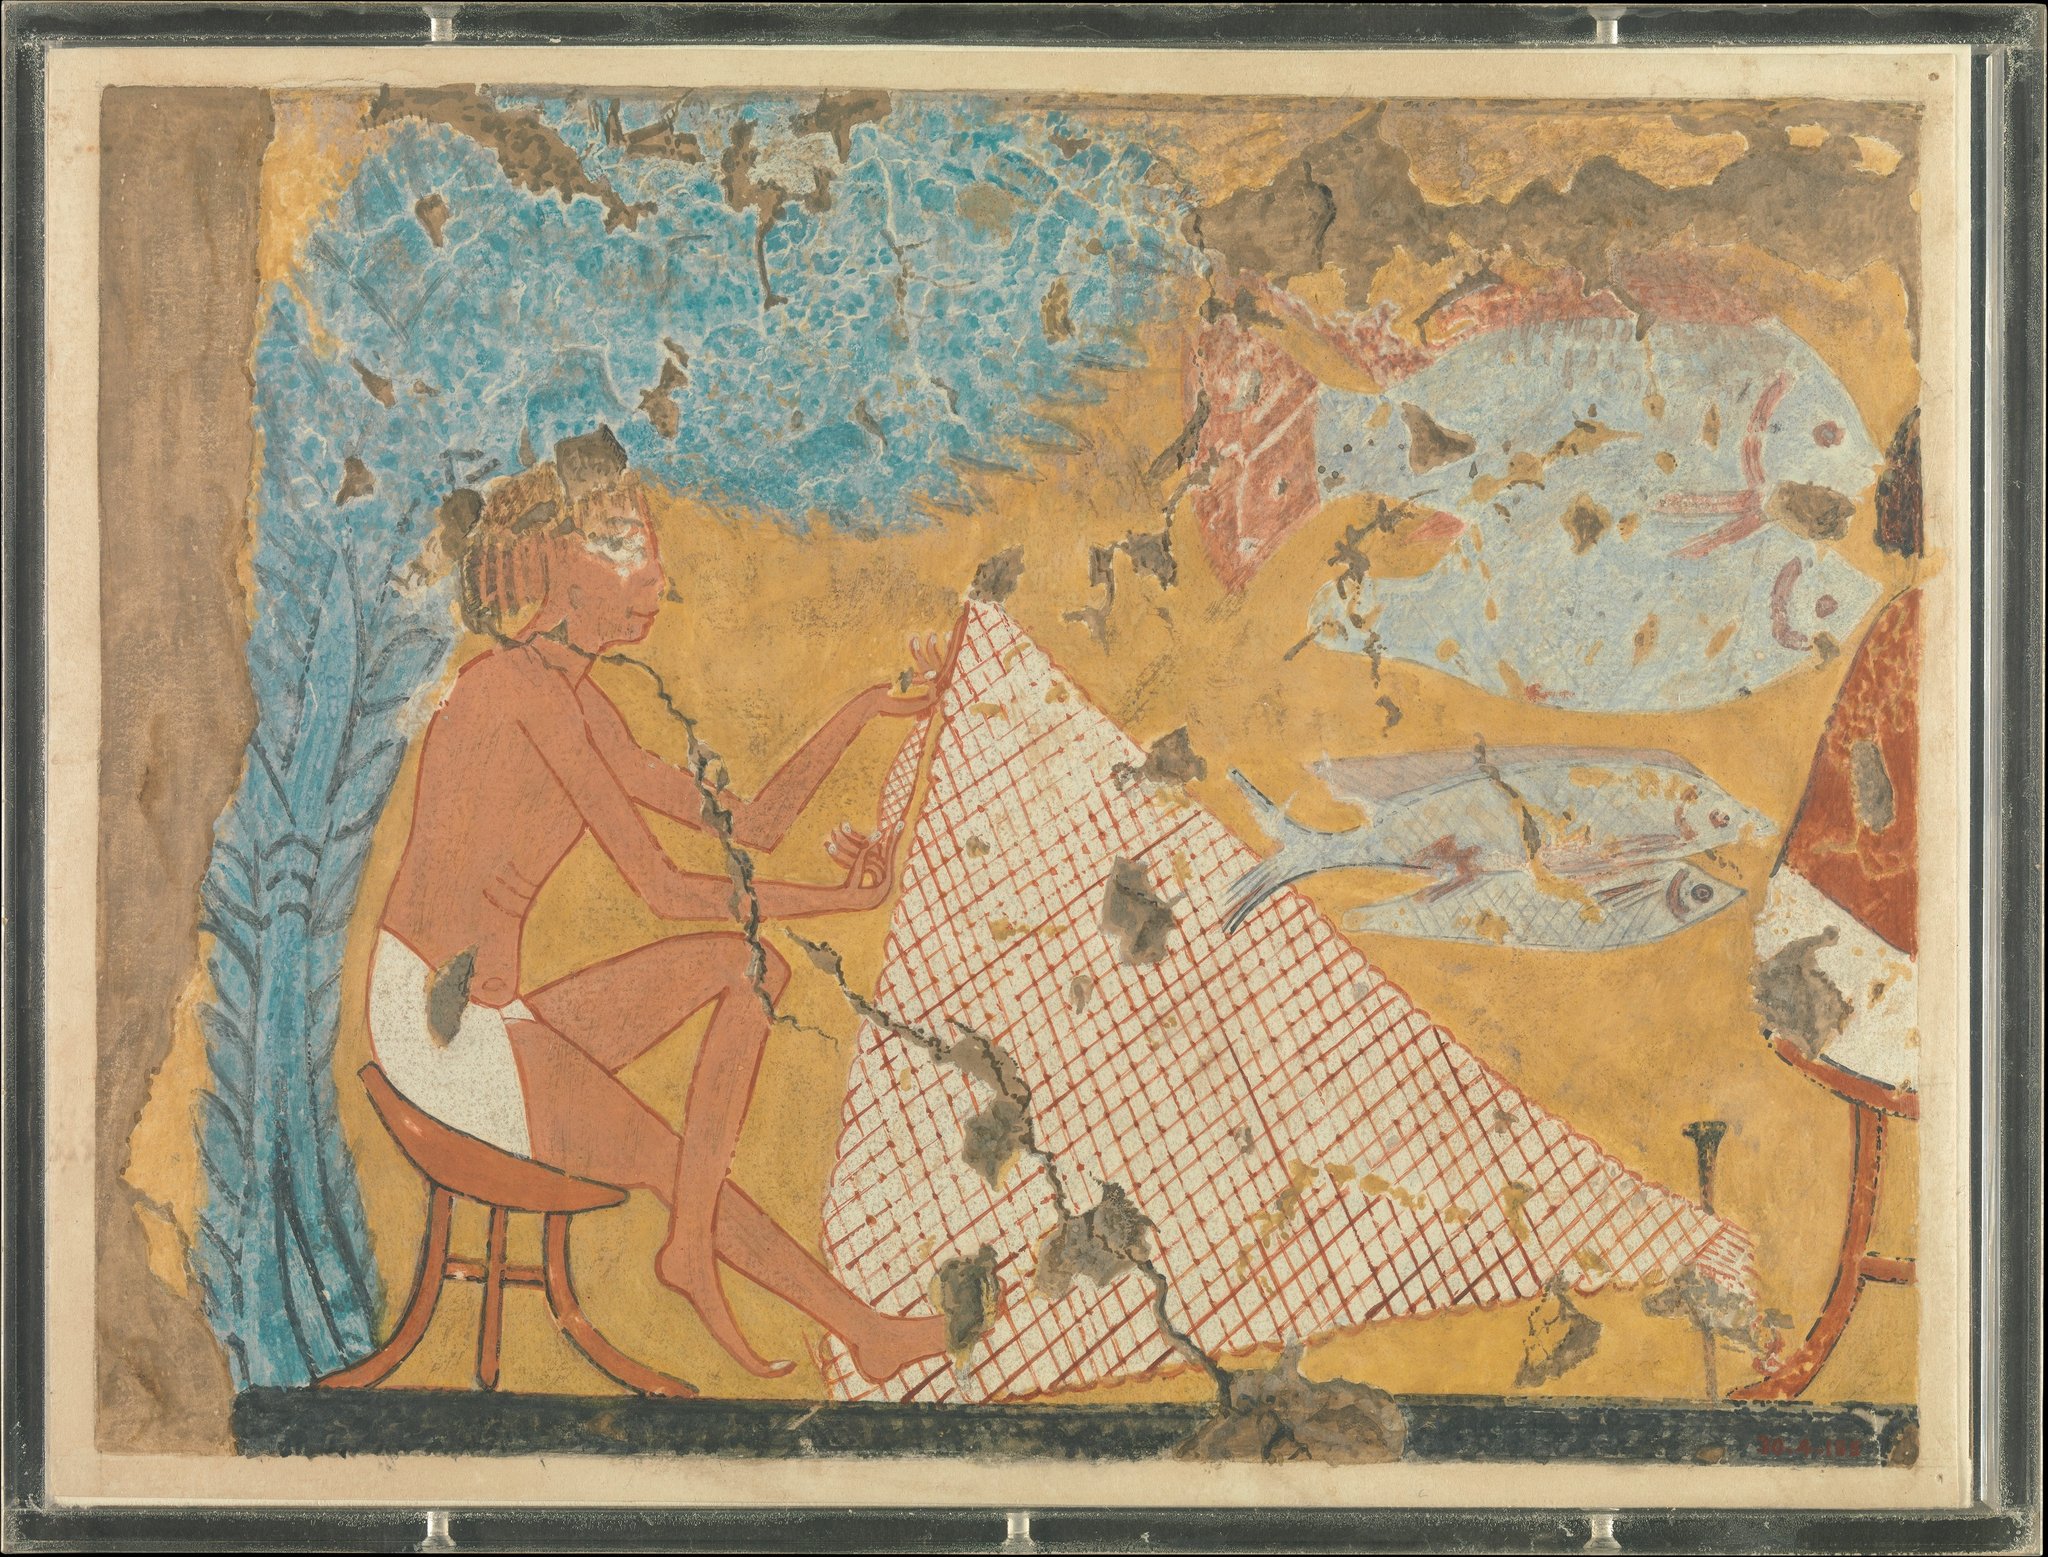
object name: facsimile, ipuy tt 217, net making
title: Man Making a Net, Tomb of Ipuy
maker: norman de garis davies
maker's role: artist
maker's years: 1865-1941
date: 1295-1213 BCE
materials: paper, paint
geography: egypt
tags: men,fish,working